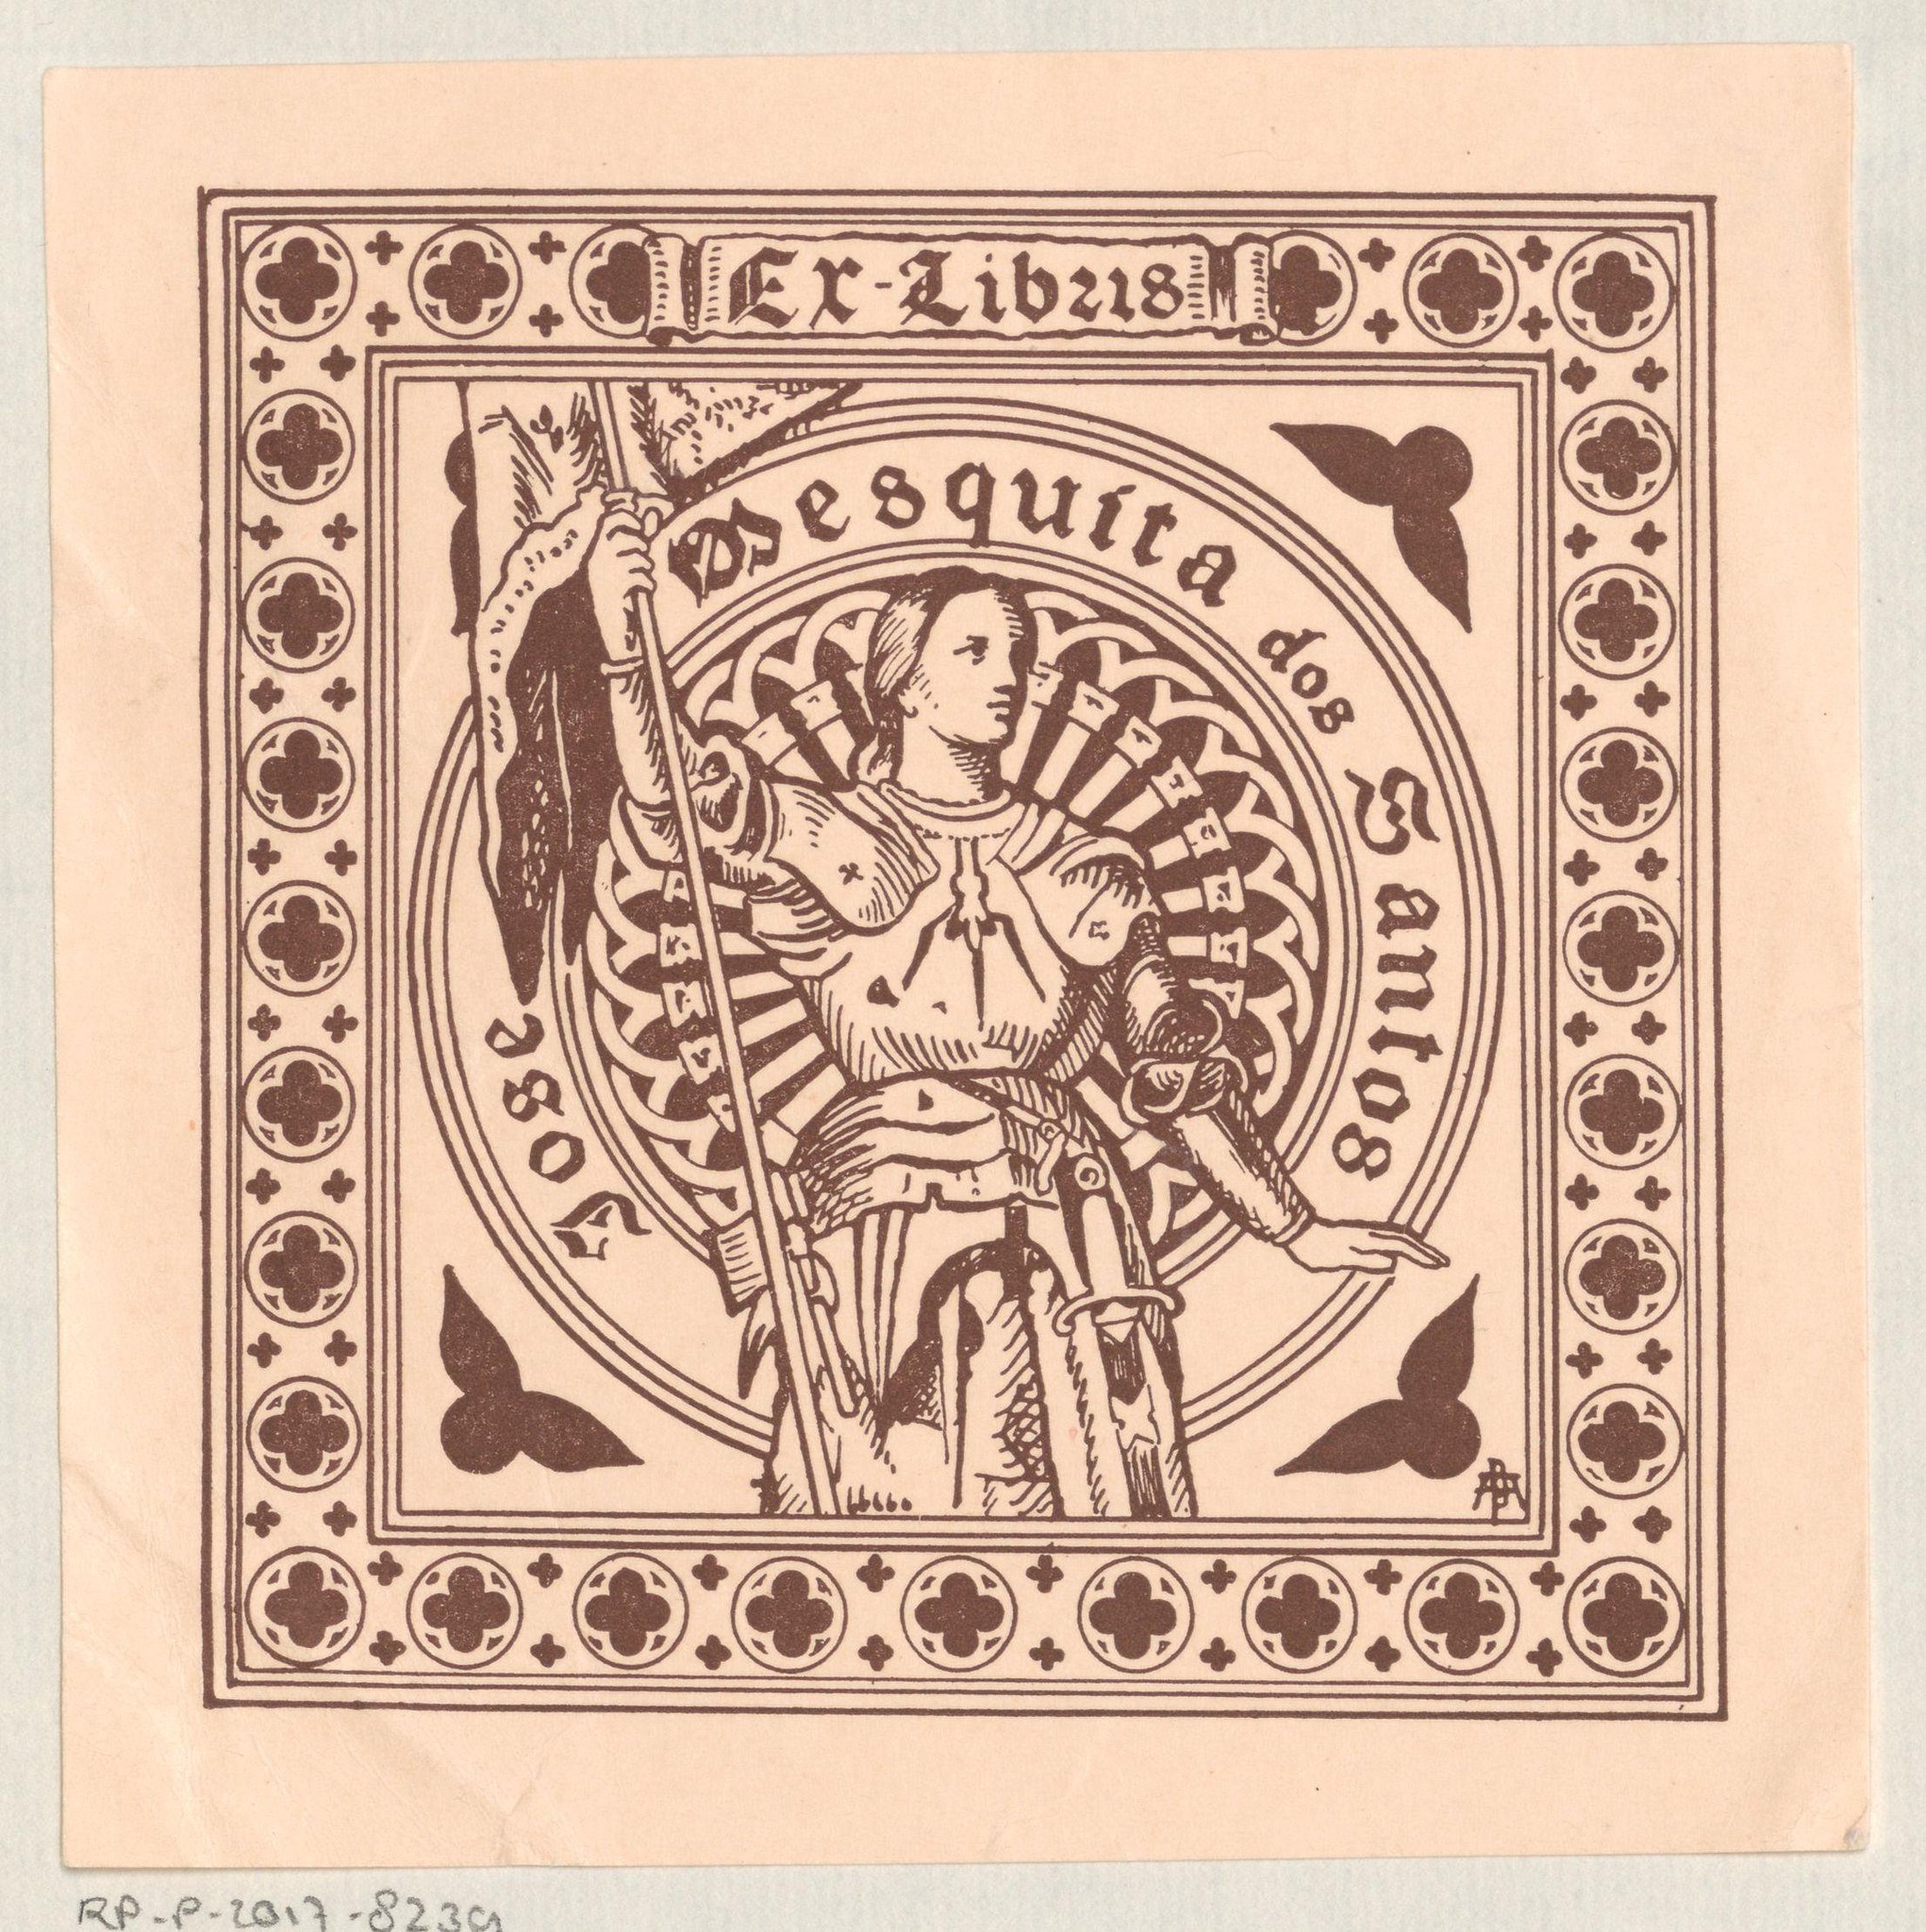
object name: bookplate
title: Ex libris van José Mesquita dos Santos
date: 1920-1944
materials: paper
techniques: printing block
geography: el masnou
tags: joan of arc (jeanne d'arc); possible attributes: armour, banner, lance, sword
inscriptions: workshop stamp: ‘J. Llop/ [...] Masnou’